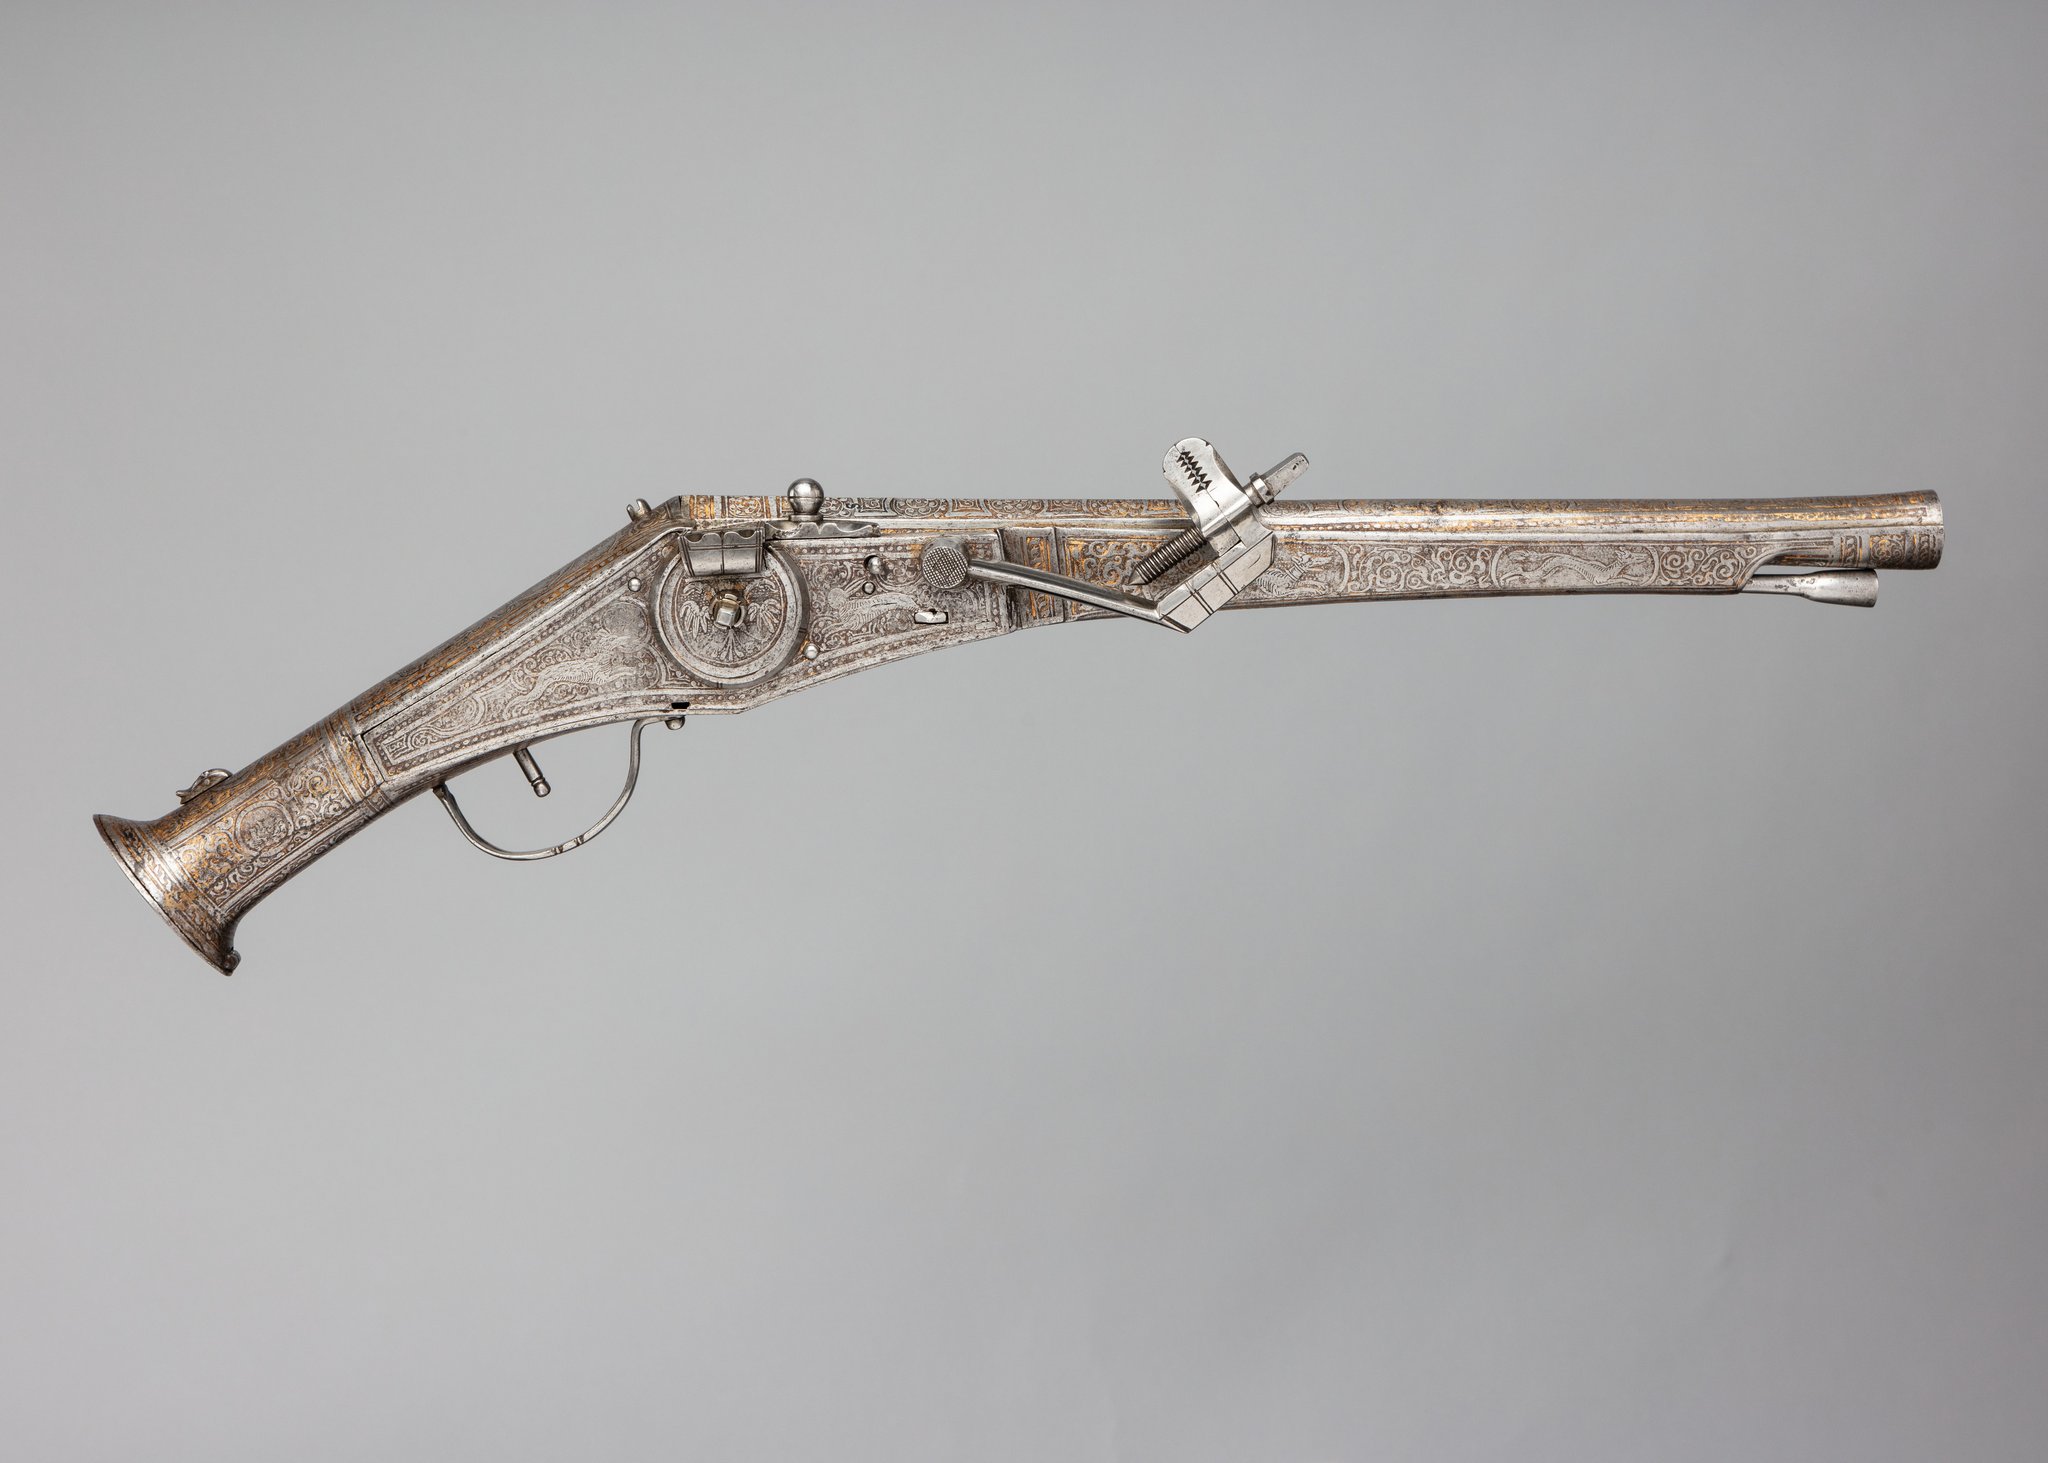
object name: wheellock pistol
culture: german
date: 1575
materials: gold, steel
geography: germany